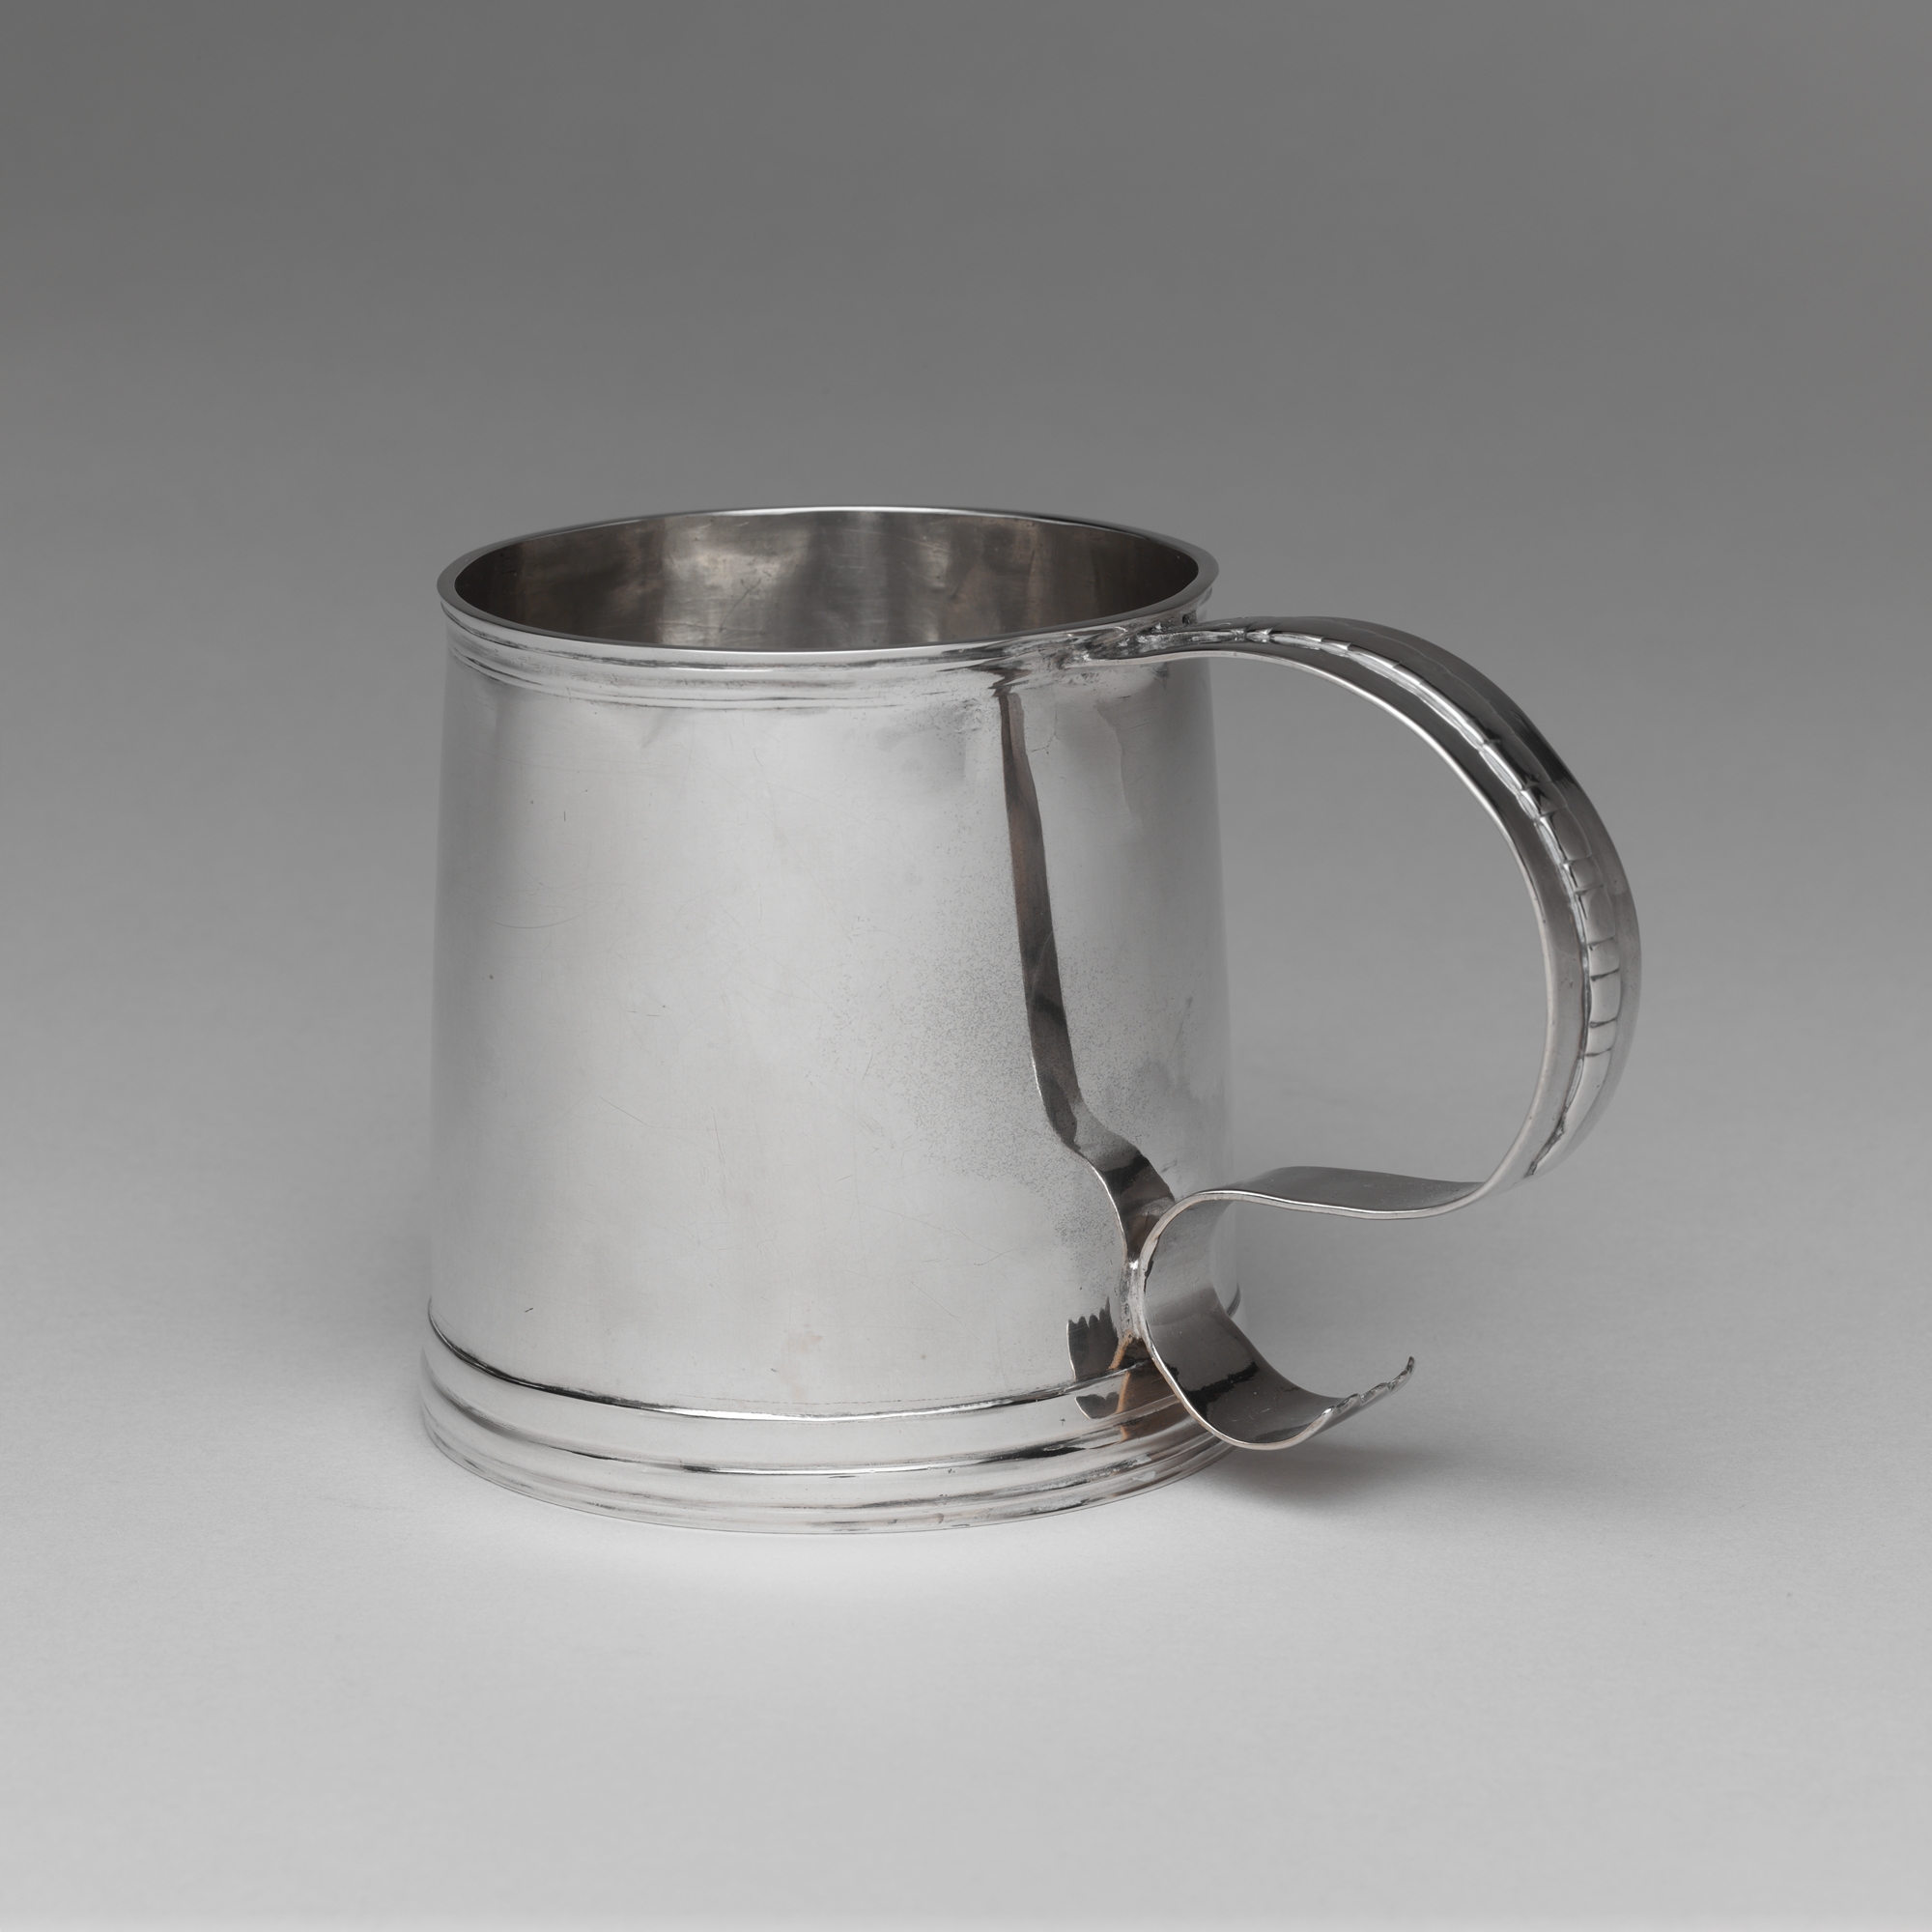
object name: mug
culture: american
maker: george fielding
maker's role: maker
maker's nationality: american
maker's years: 1728-1765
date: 1740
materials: silver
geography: united states